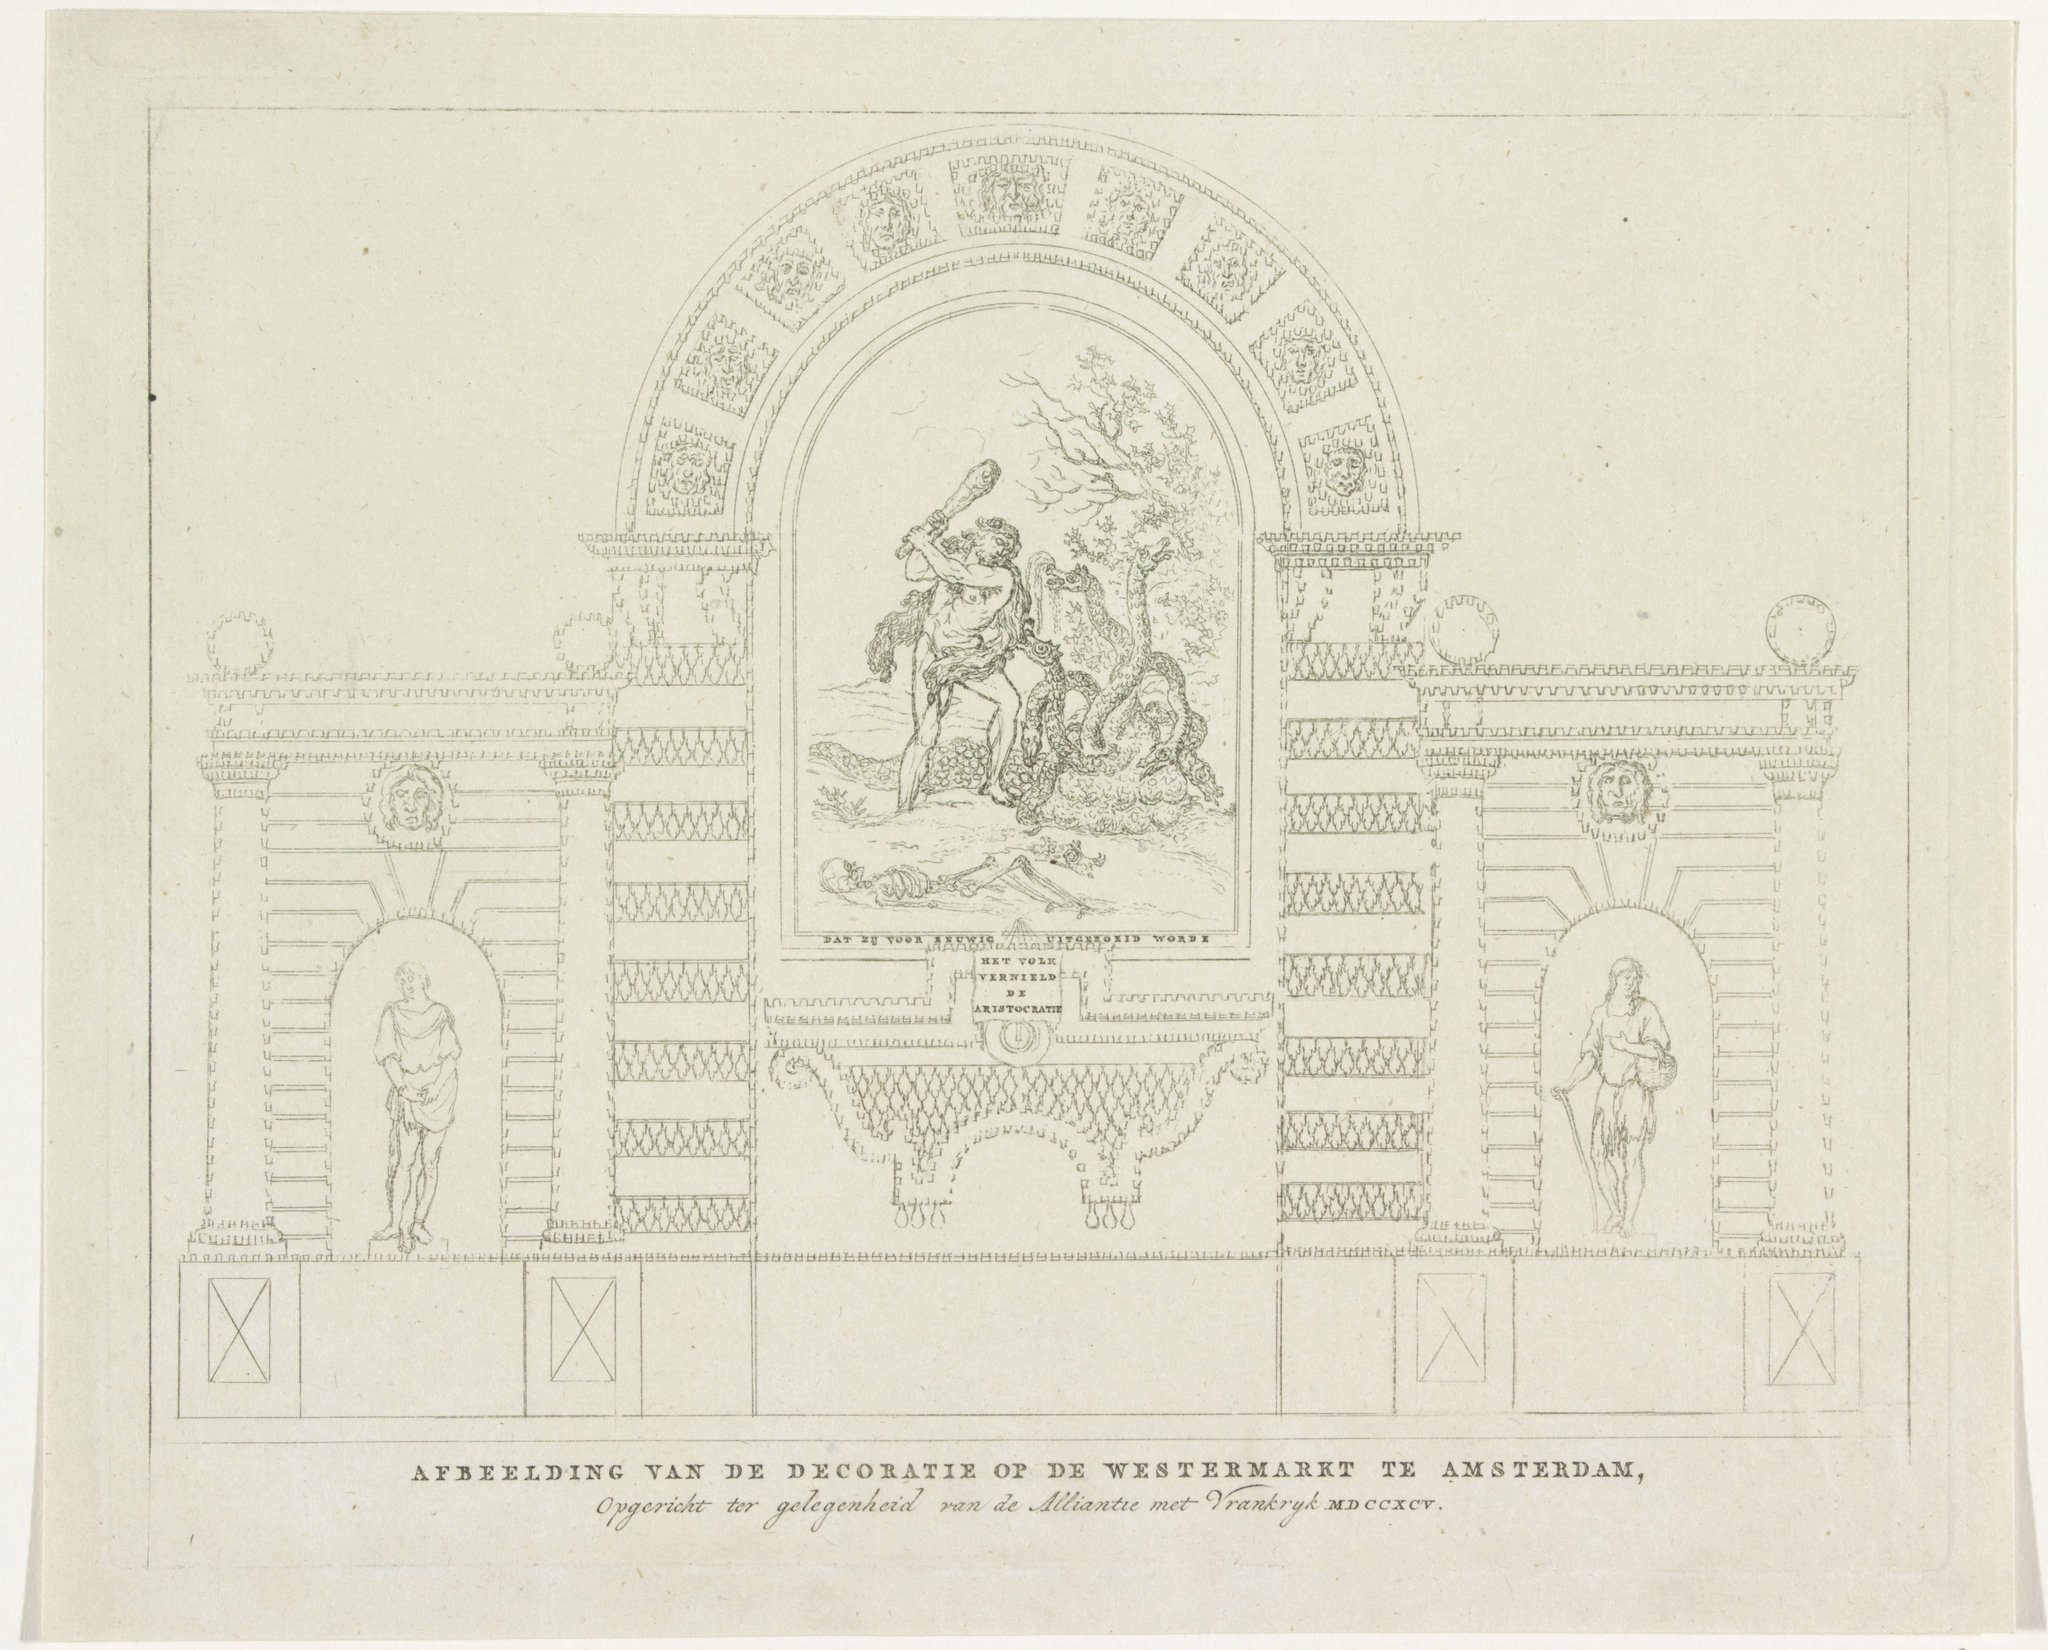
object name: print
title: Vernietiging der Aristocratie, decoratie op de Westermarkt, 1795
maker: Anonymous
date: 1795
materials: paper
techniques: etching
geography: netherlands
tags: (2) the hydra of lerna is killed by hercules, festivities on events of national importance (+ festive decoration ~ festive activities), amsterdam, alliance with france (1795)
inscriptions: collector's mark: Lugt 2228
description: De Vernietiging der Aristocratie, allegorische decoratie opgericht op de Westermarkt te Amsterdam bij het Alliantiefeest op 19 juni 1795. Hercules (het Nederlandse volk) verslaat de zevenkoppige hydra (aristocratie en familieregering). Onderdeel van een serie van tien platen.